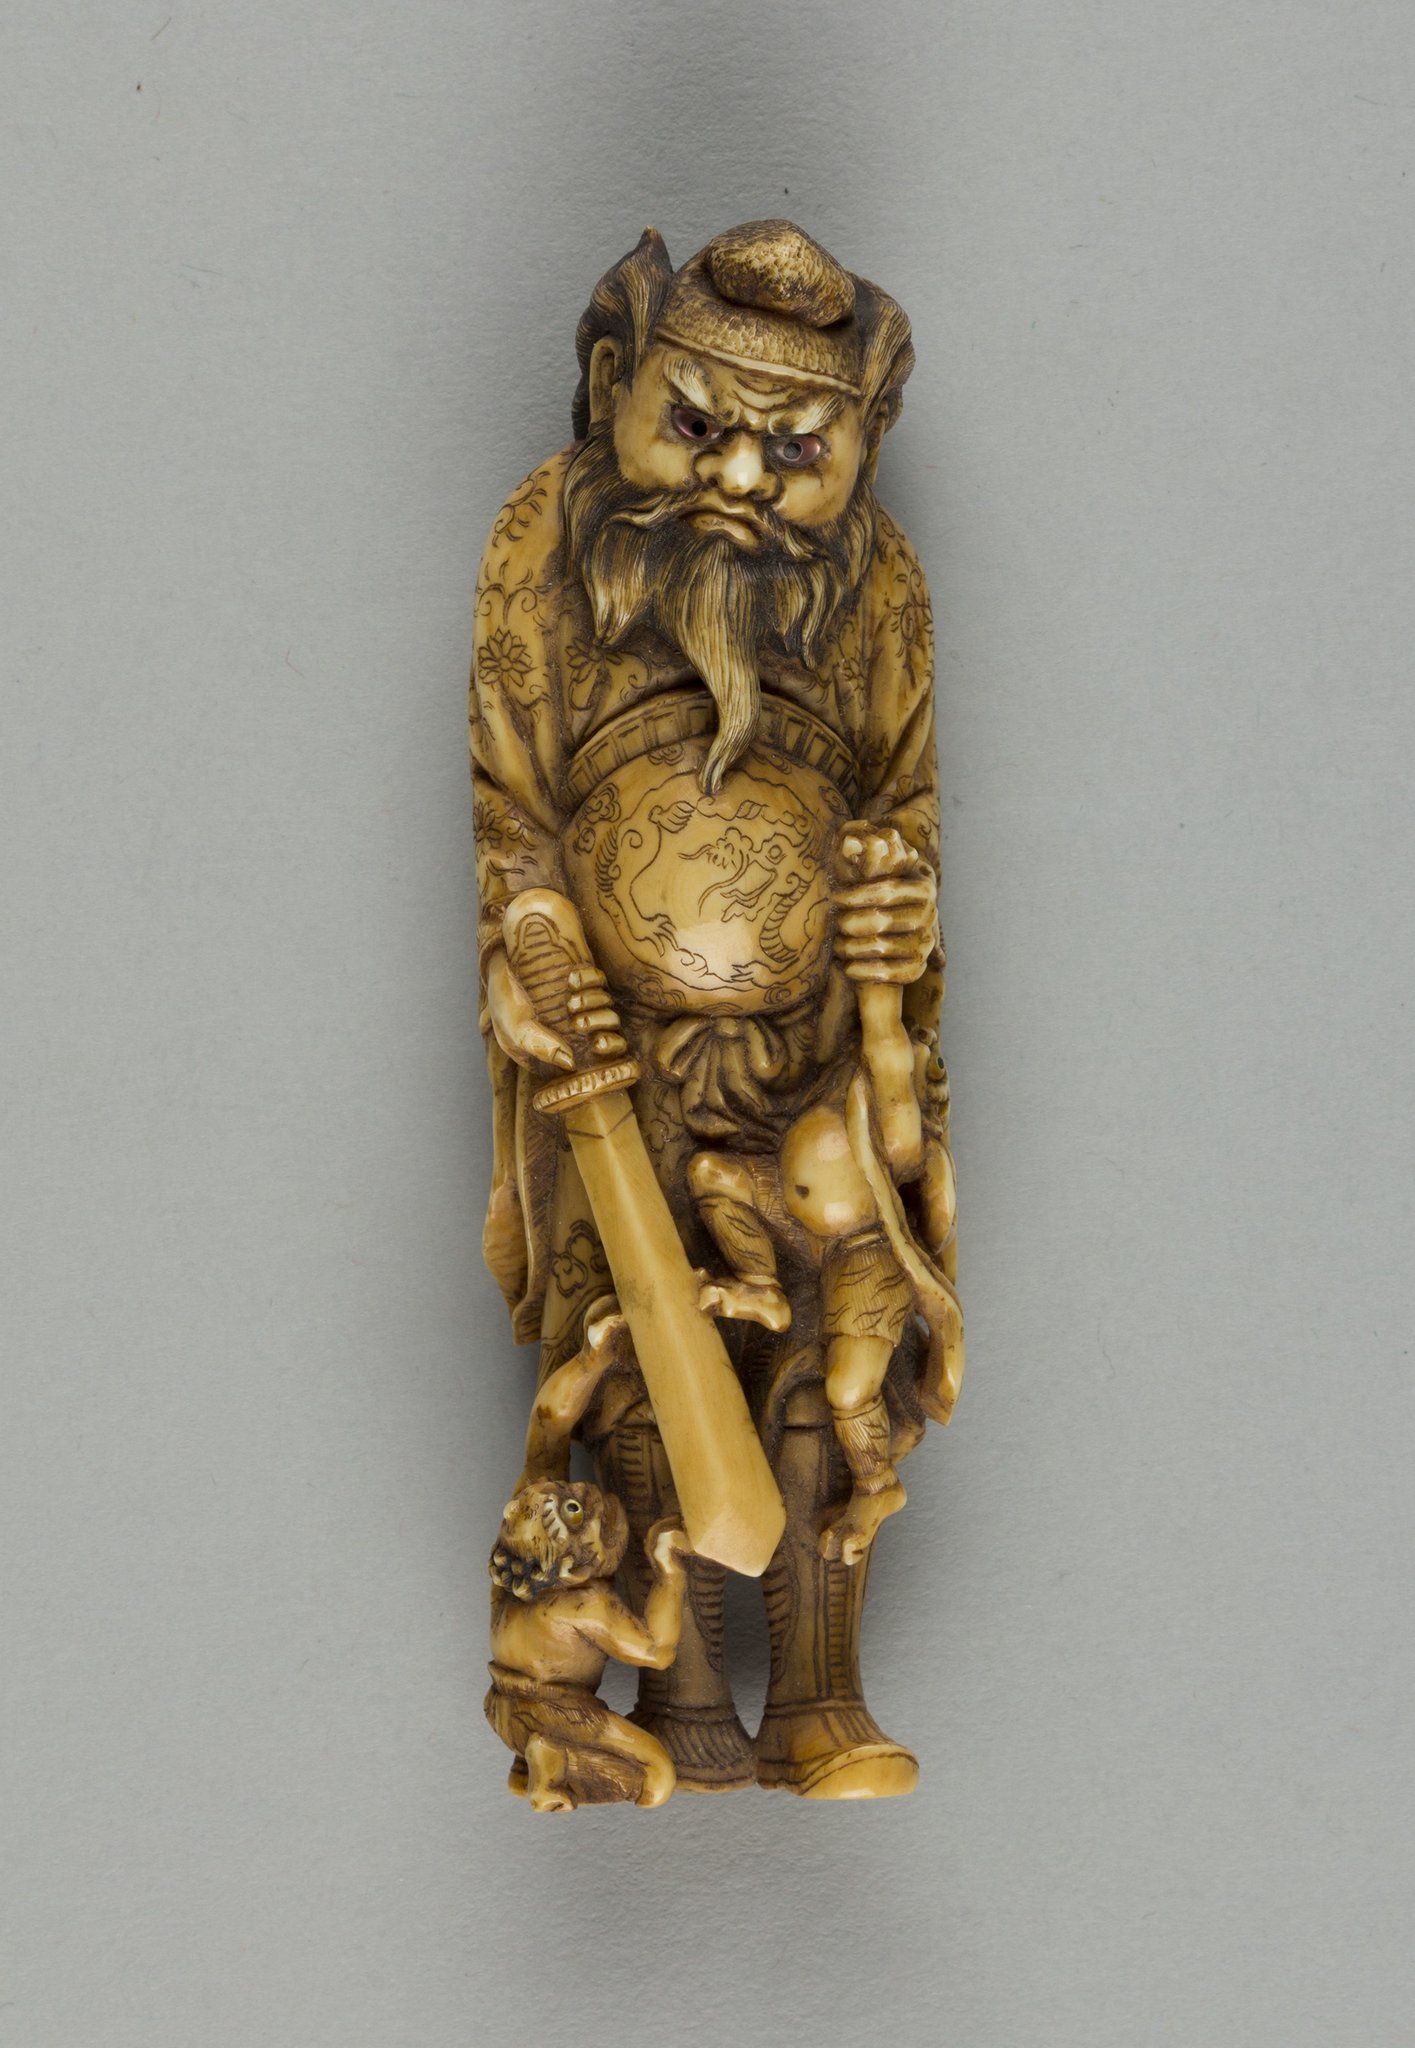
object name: netsuke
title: Netsuke of a Man and Two Demons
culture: japanese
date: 1701-1900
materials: ivory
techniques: inlay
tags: demons